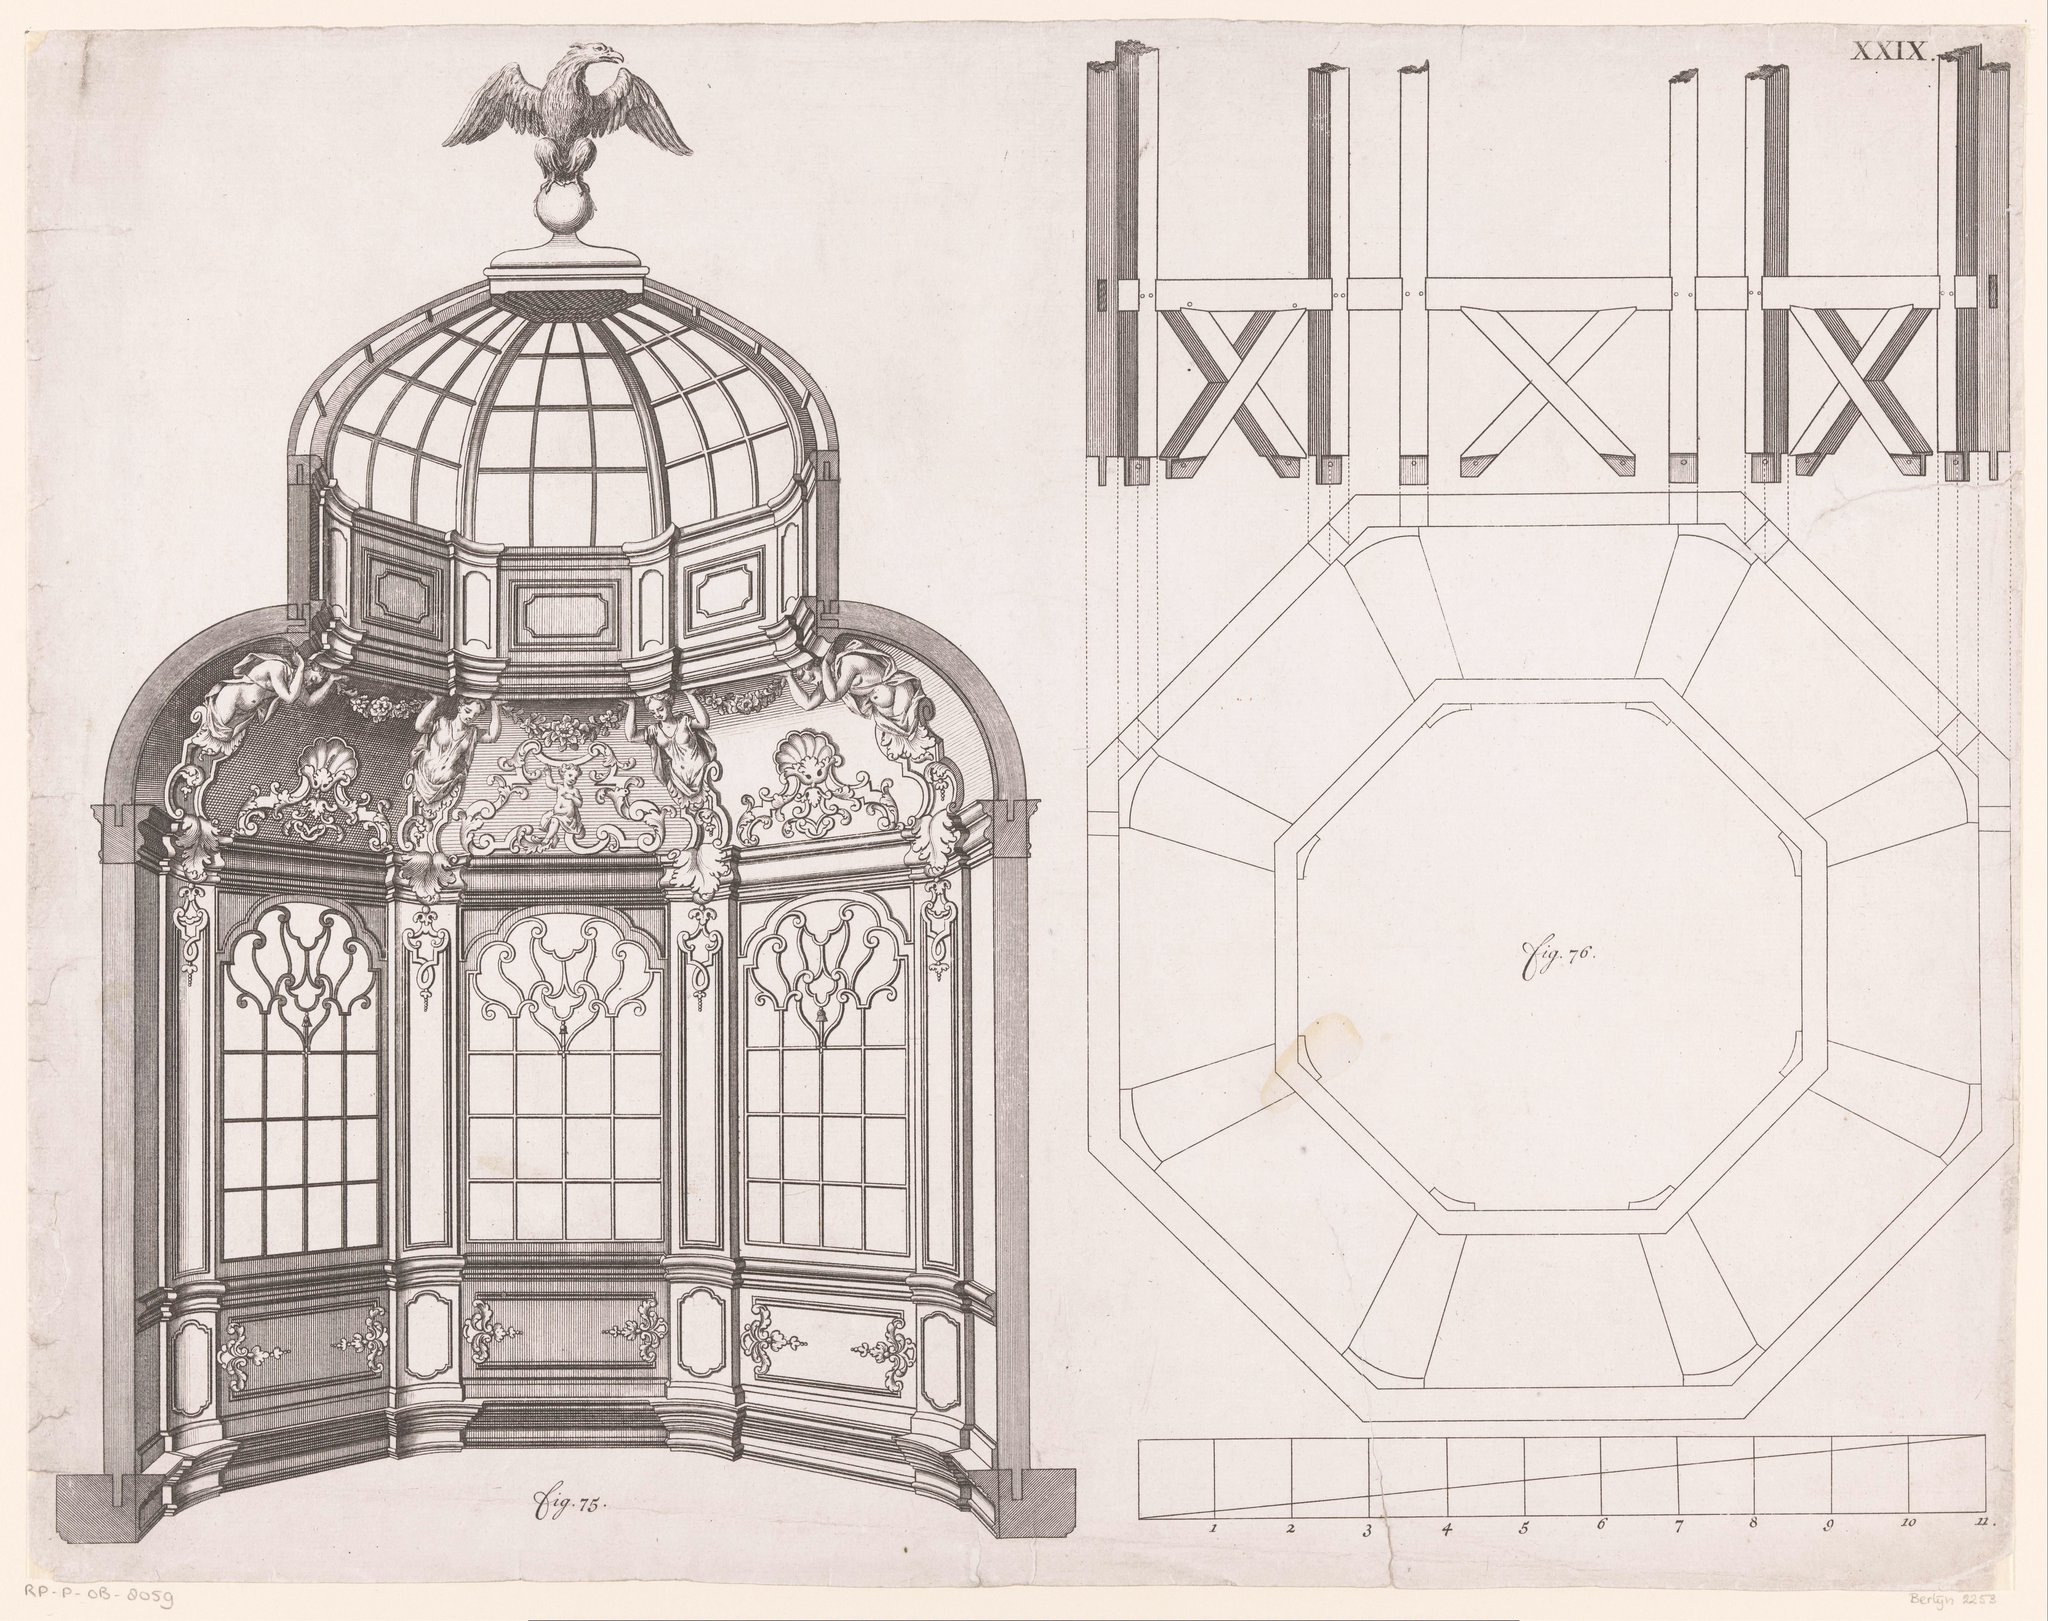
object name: ornament print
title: Technische tekeningen van koepelgebouw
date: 1739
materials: paper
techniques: engraving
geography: amsterdam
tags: drawing (mathematics), other architectural details (cupola)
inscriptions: collector's mark: Lugt 2228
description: Technische tekeningen van een geornamenteerd koepelgebouw met kariatiden, schelpmotiefen, guirlandes en bekroond met een adelaar (nummers 75). Bovenaanzicht en dwarsdoorsnede